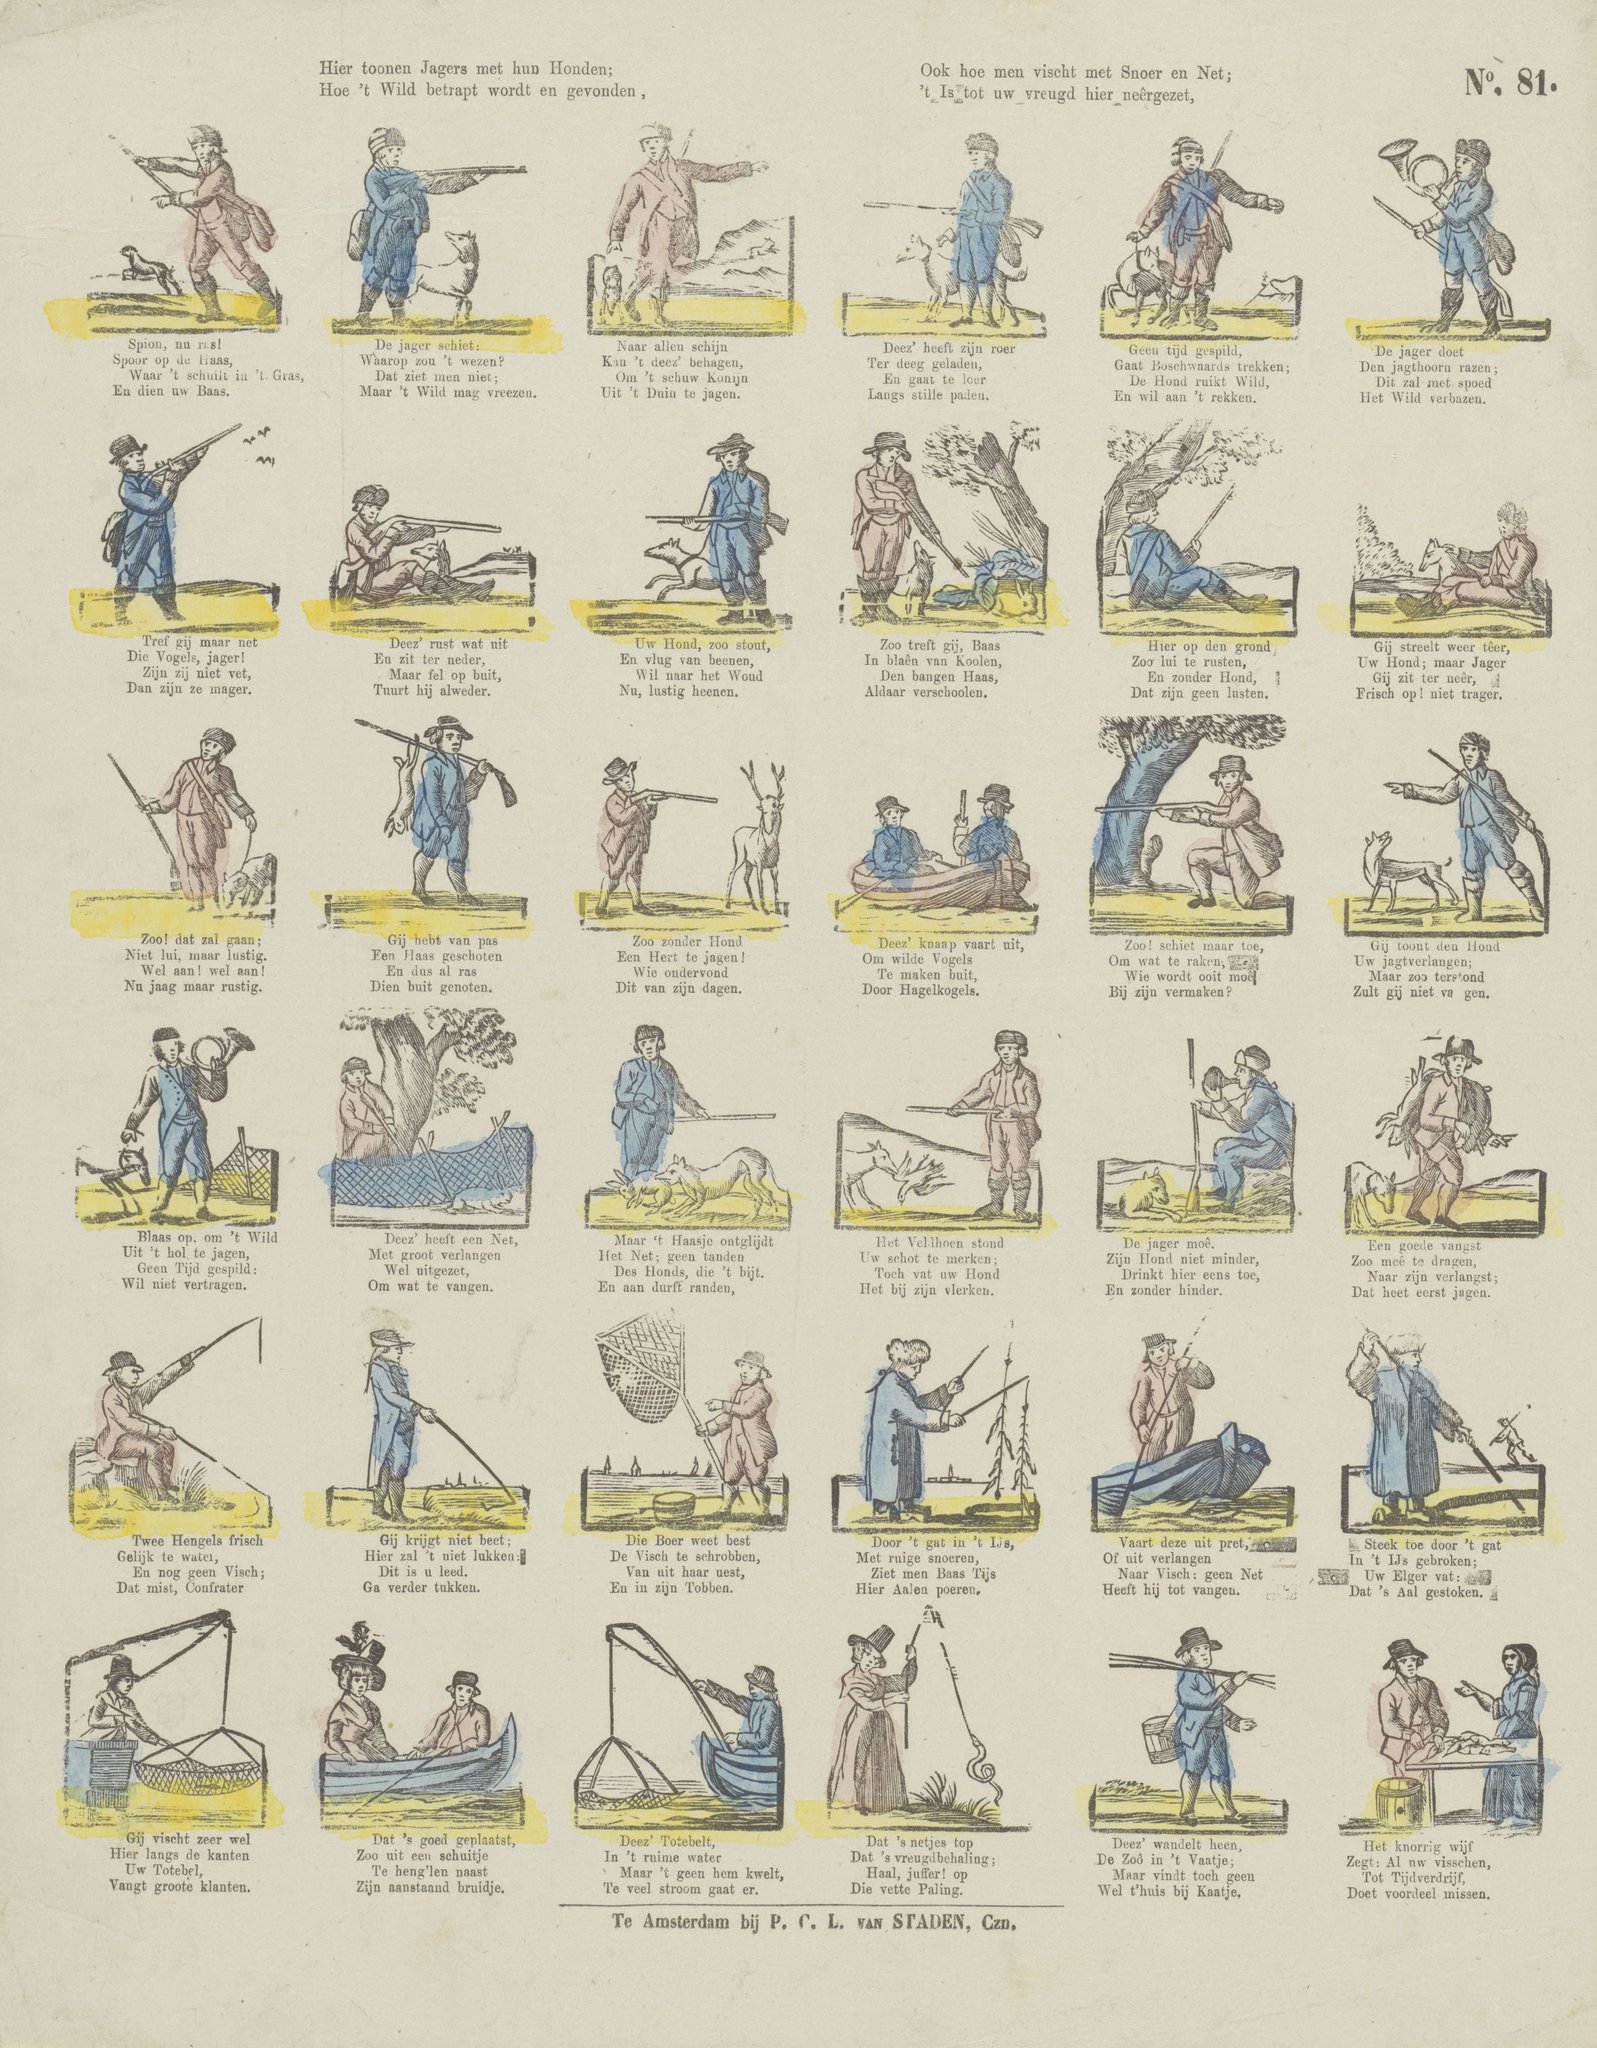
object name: popular print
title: Hier toonen jagers met hun honden; / Hoe 't wild betrapt wordt en gevonden, / Ook hoe men vischt met snoer en net; / 't is tot uw vreugd hier neergezet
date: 1850-1870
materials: paper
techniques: colour, letterpress printing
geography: netherlands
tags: hunting dogs, hunter, hunters hunting (n.b.: in 1988-1990 this notation denoted the concept of 43c11421 'hunters resting during the hunt'), fisherman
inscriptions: collector's mark: Lugt 2760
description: Blad met 36 voorstellingen van jagers en vissers. Onder elke voorstelling een vierregelig vers. Genummerd rechtsboven: No. 81.